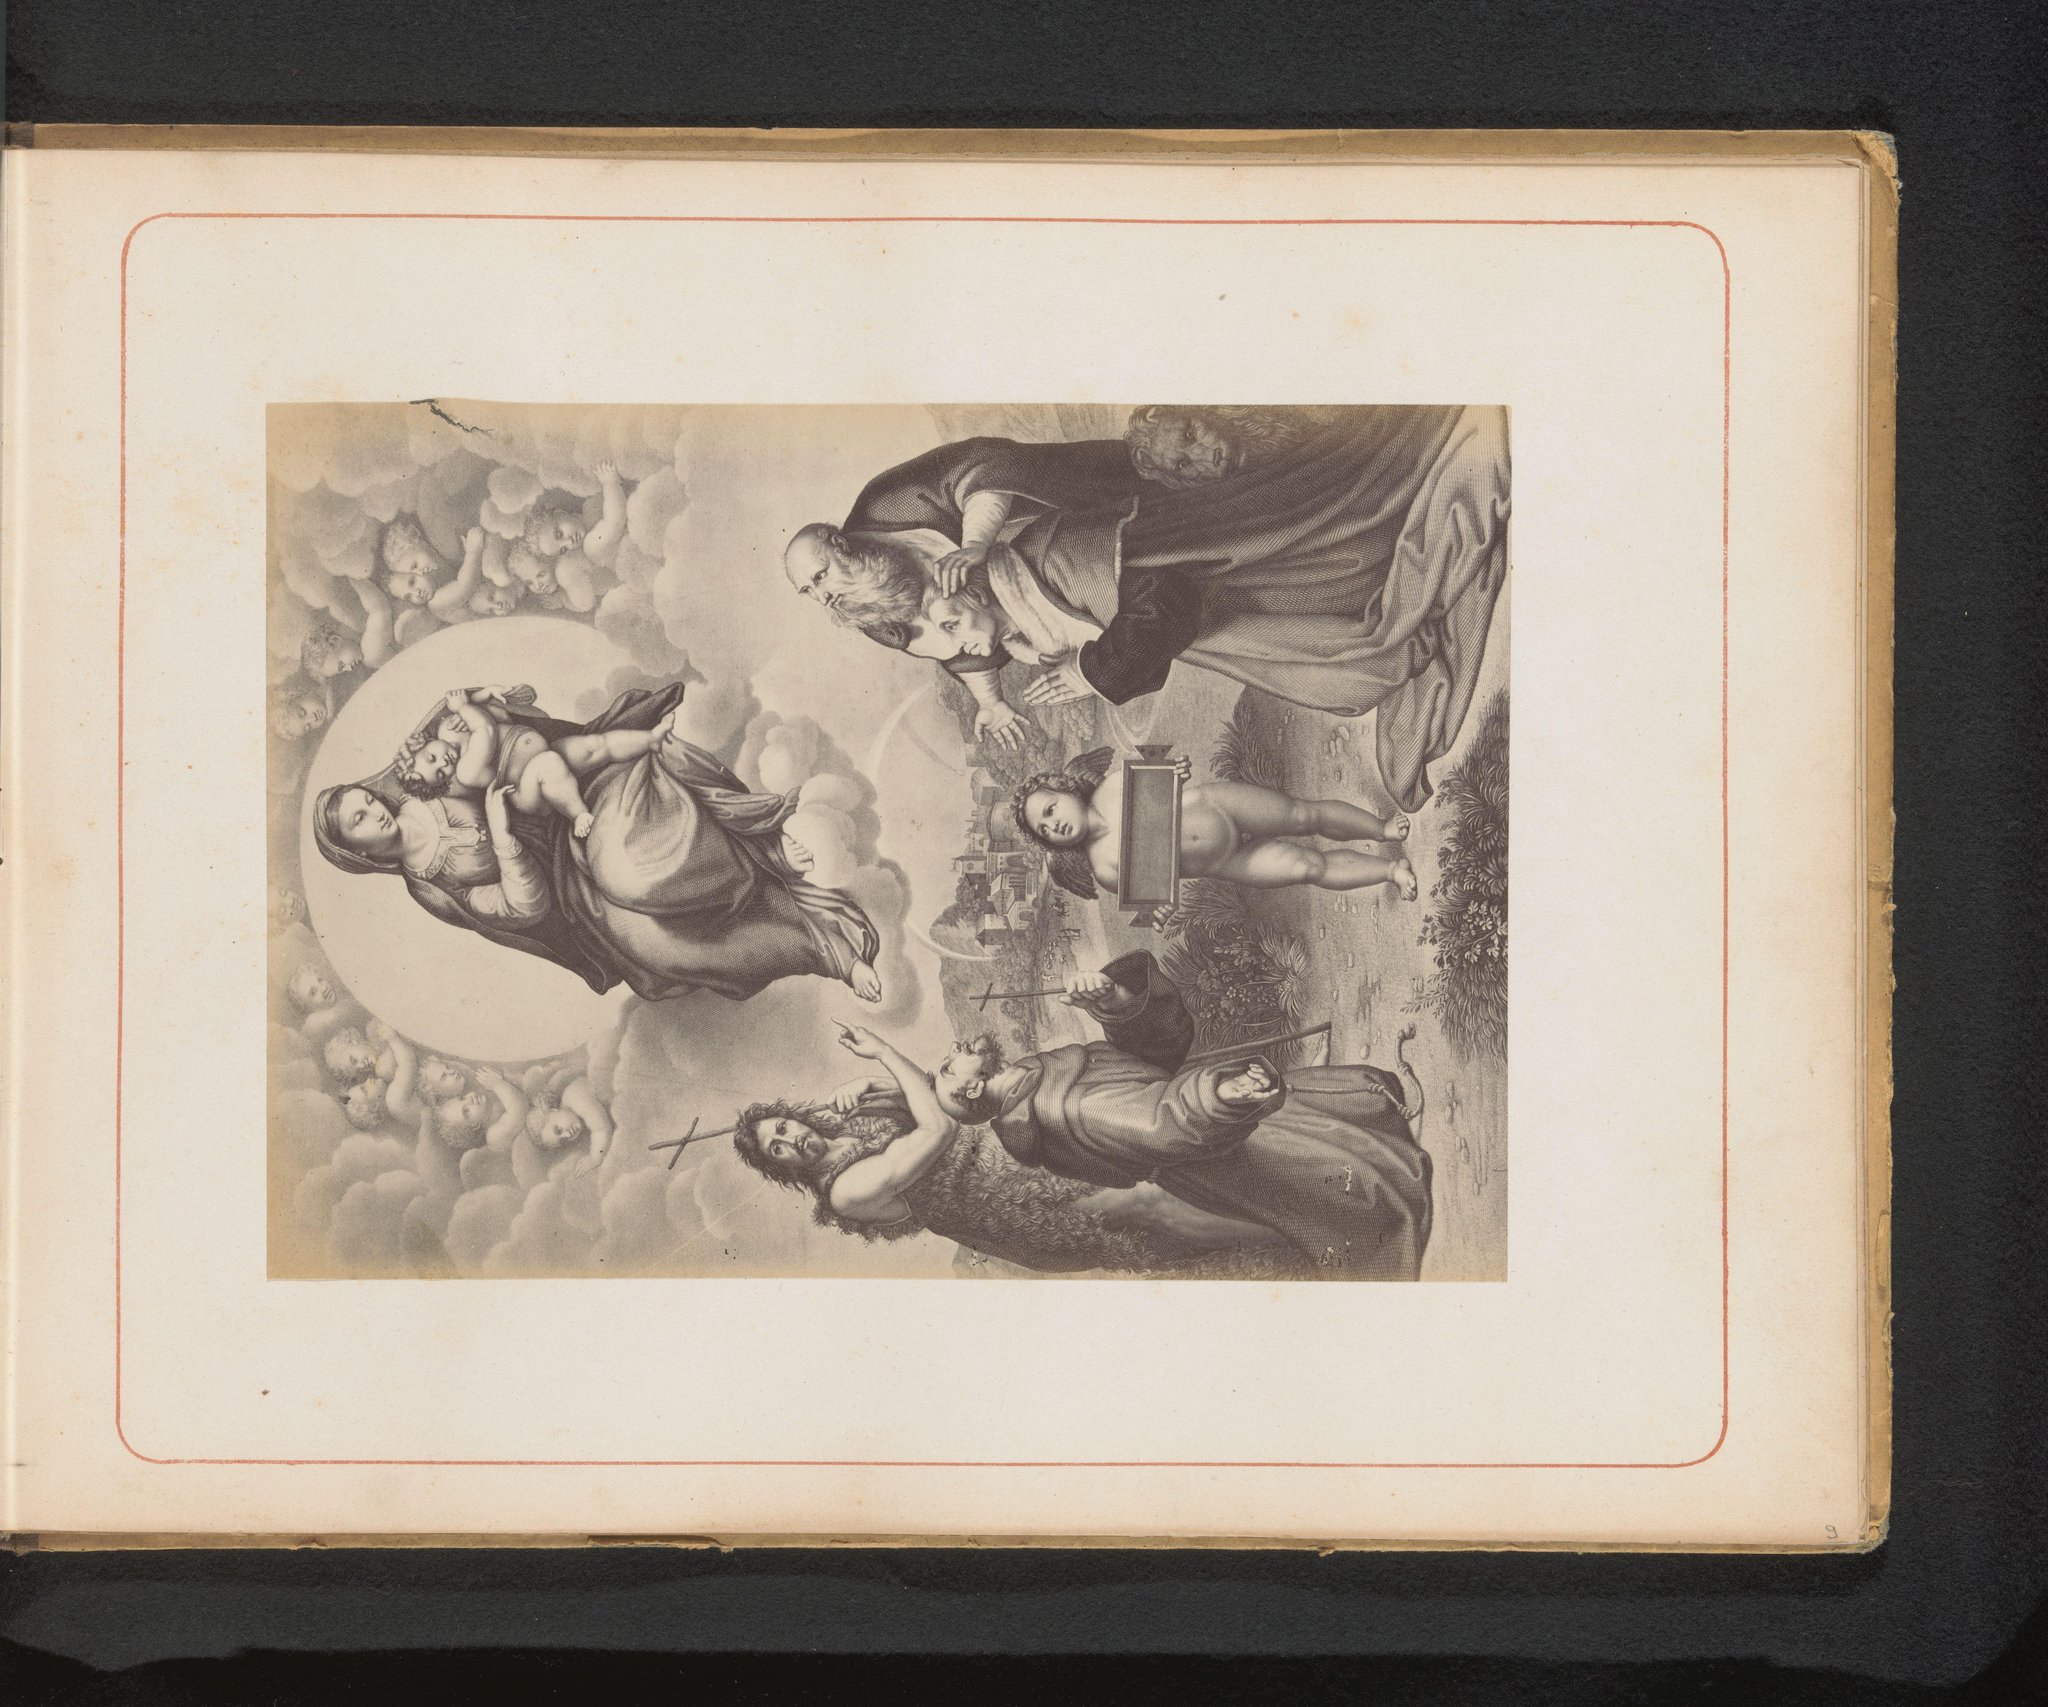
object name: page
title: Fotoreproductie van een gravure naar De Madonna van Foligno door Rafaël in het Vaticaan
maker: Anonymous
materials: photographic support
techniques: albumen print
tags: madonna: i.e. mary with the christ-child